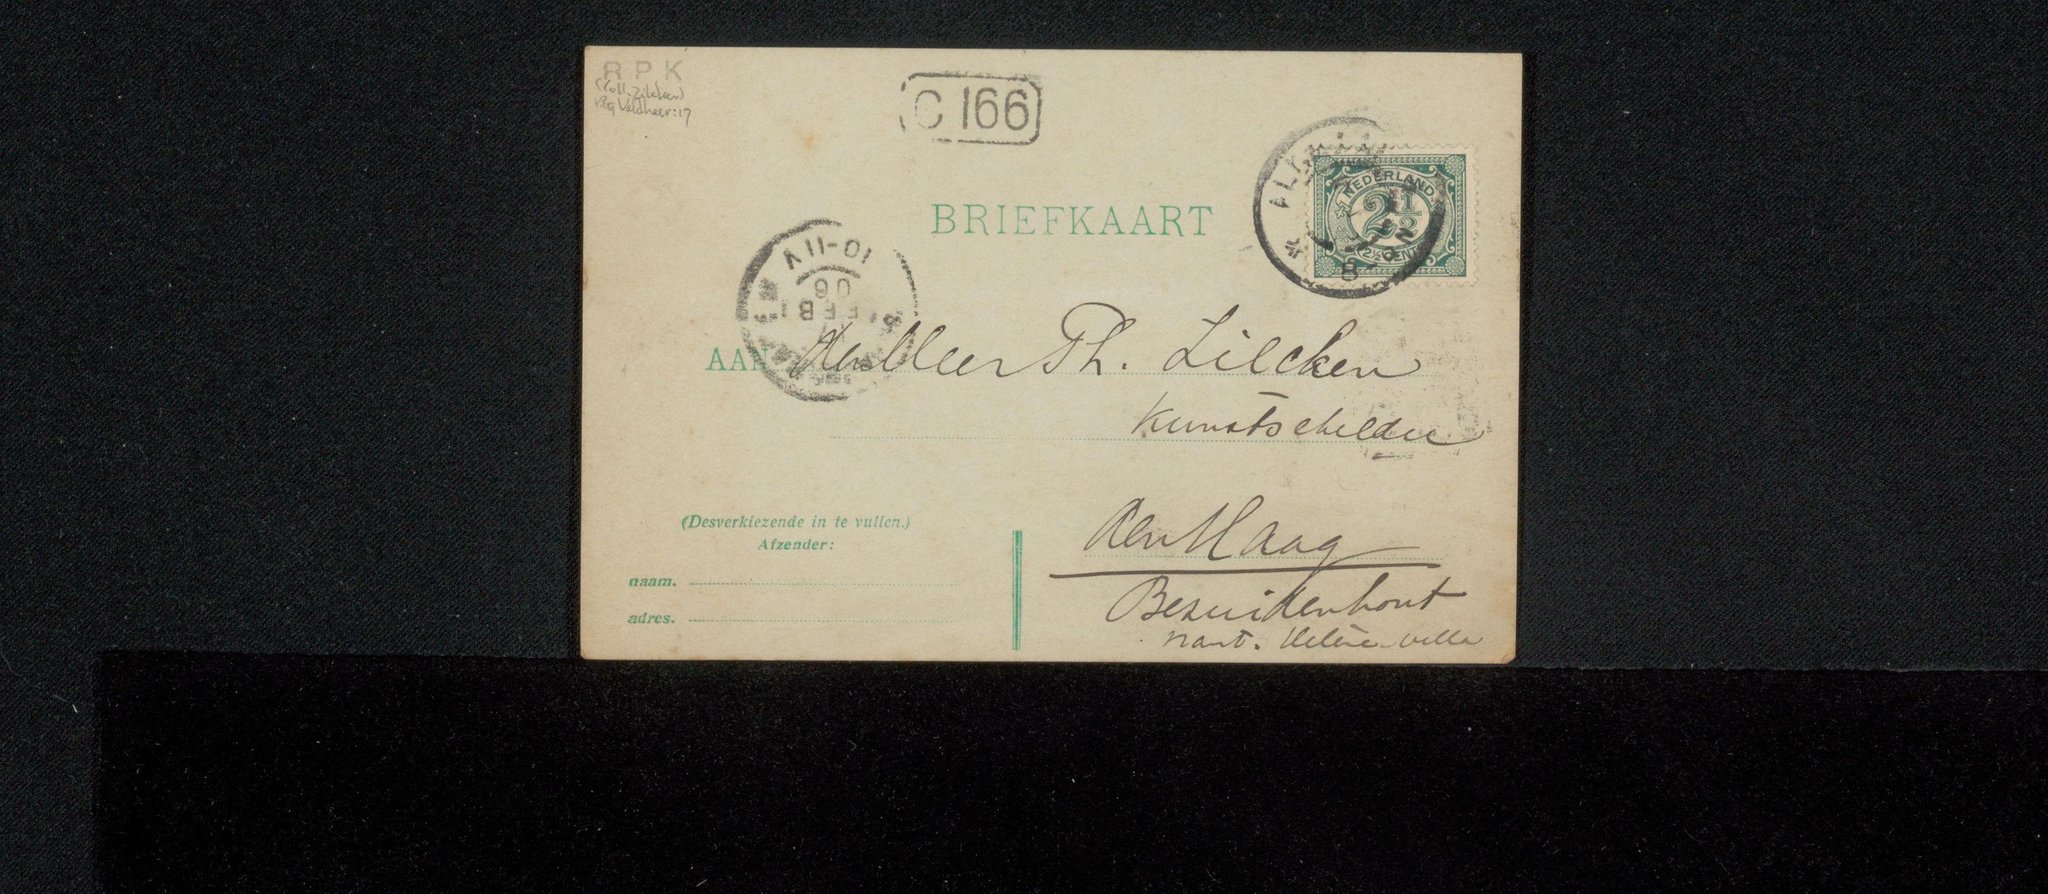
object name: postcard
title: Briefkaart aan Philip Zilcken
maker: jacobus gerardus veldheer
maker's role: draughtsman, print maker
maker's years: 1866-1954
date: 1906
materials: cardboard, ink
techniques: pen, writing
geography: bergen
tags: johannes mattheus graadt van roggen, painter, draughtsman, philip zilcken, exhibition ~ art, money, venice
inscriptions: collector's mark: ‘RPK’